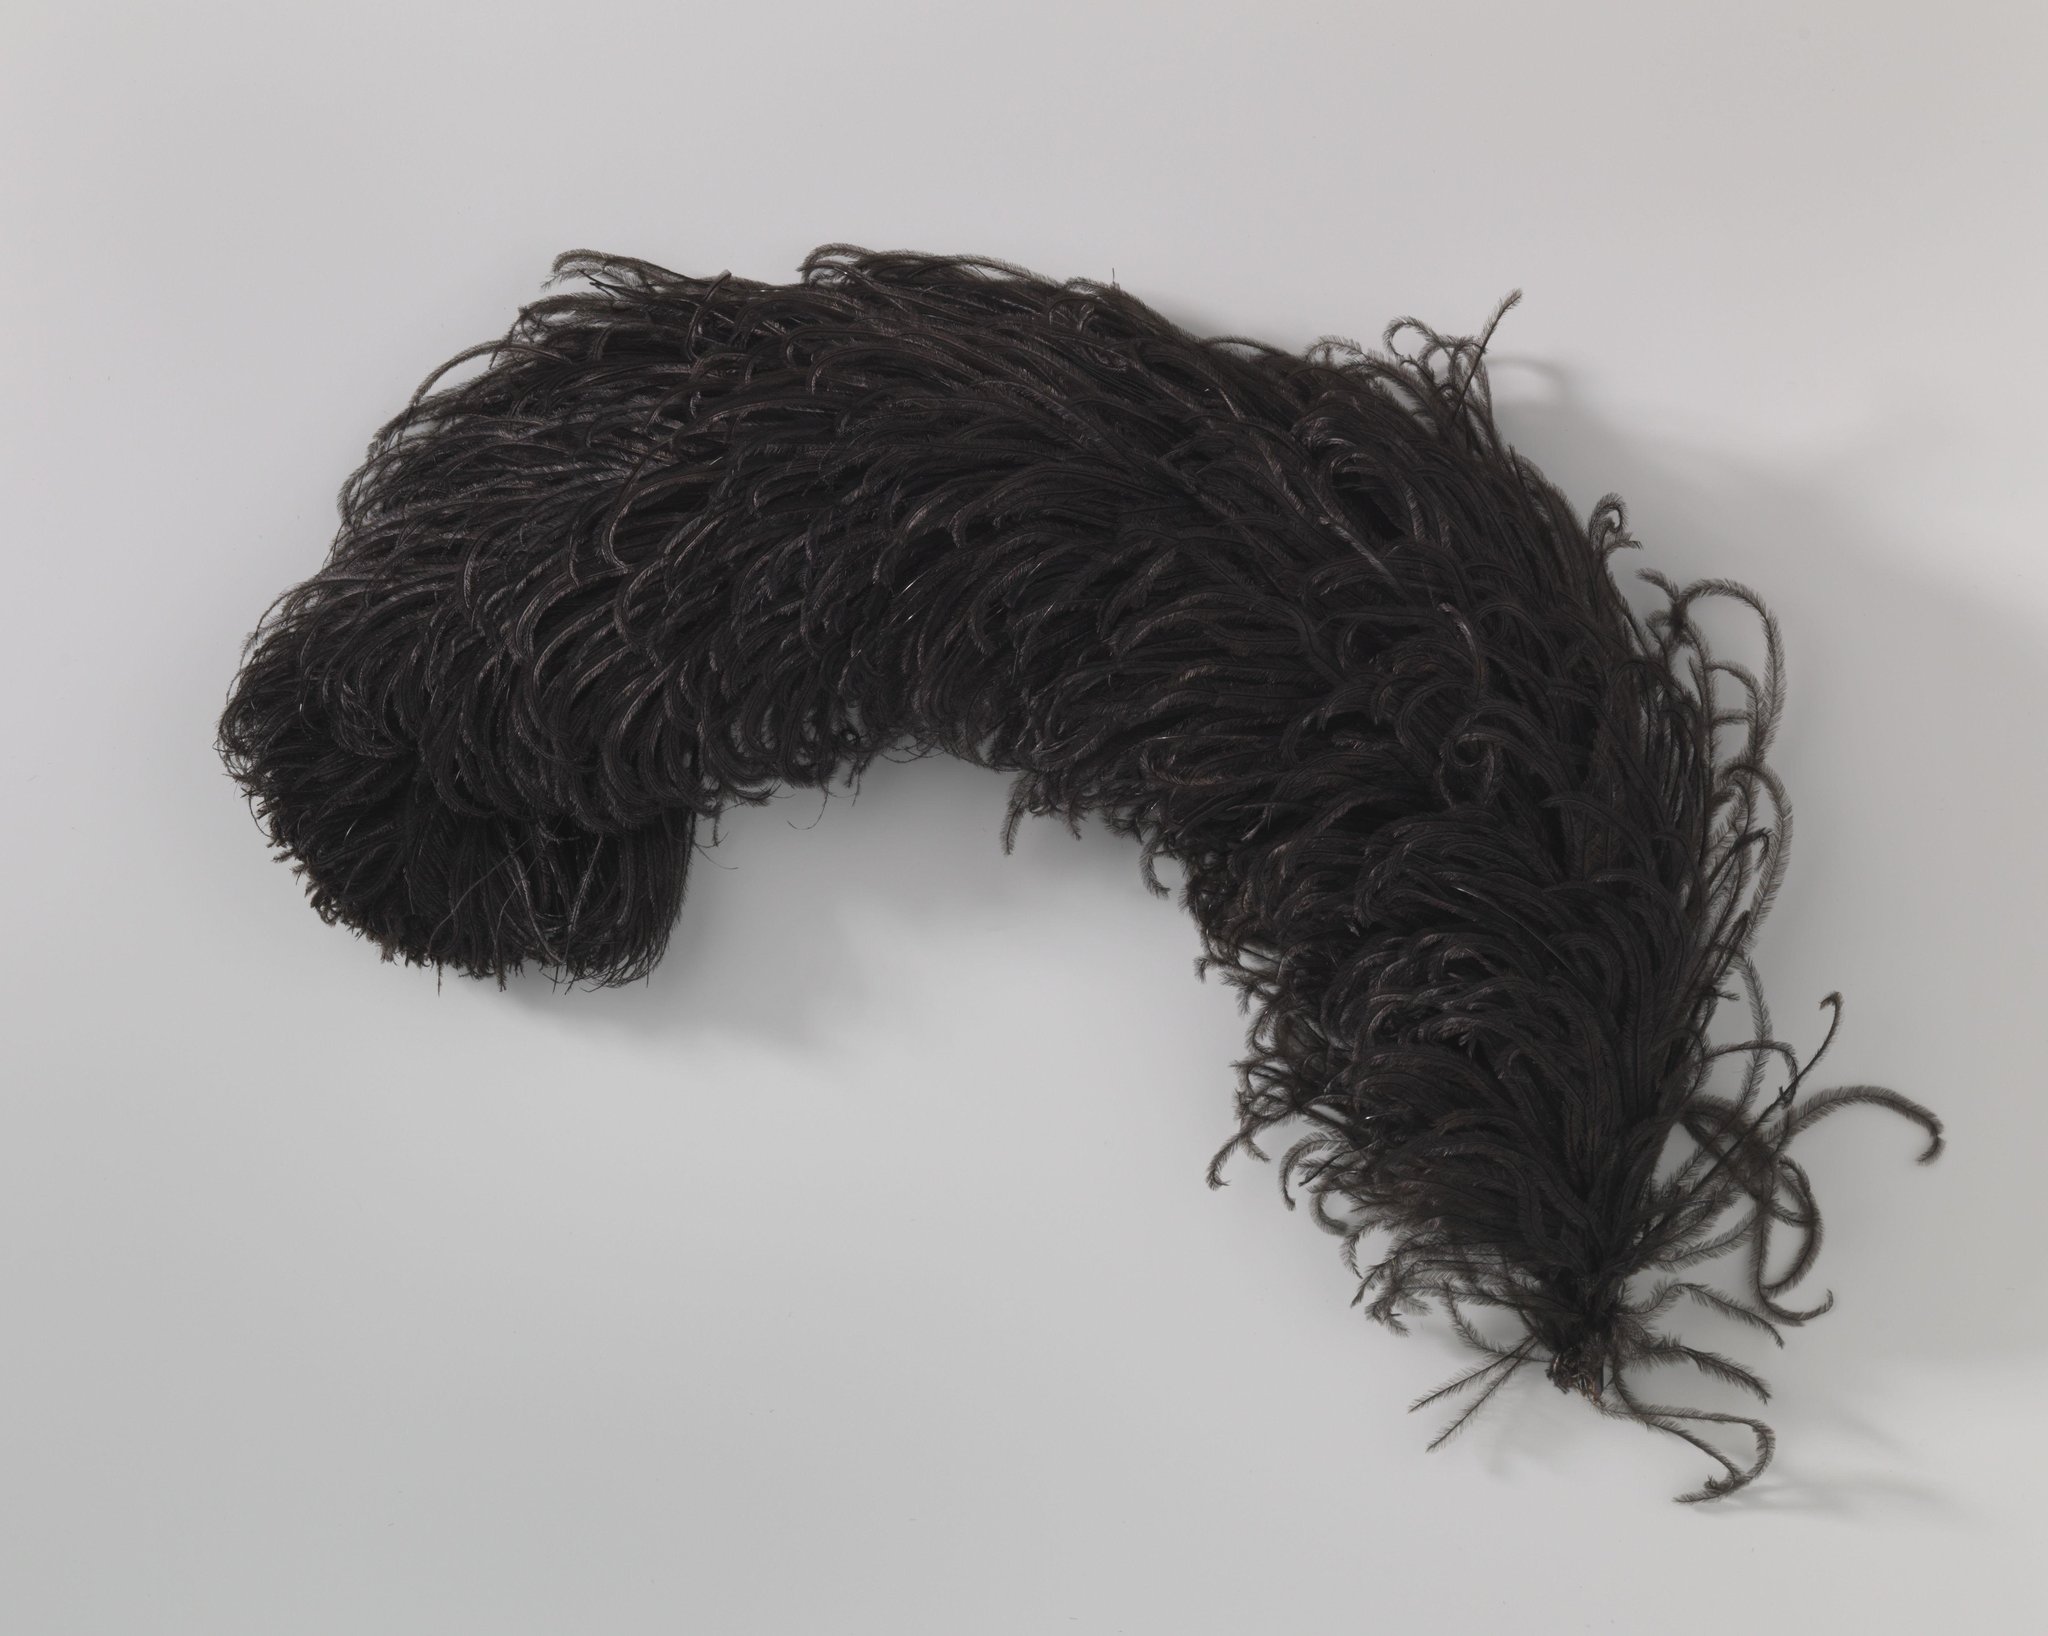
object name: hoedenveer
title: Toef struisveren, zwart, met sterk gebogen uiteinde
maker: Anonymous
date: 1880-1925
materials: metal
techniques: painting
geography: western europe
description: Toef struisveren, zwart, met sterk gebogen uiteinde.